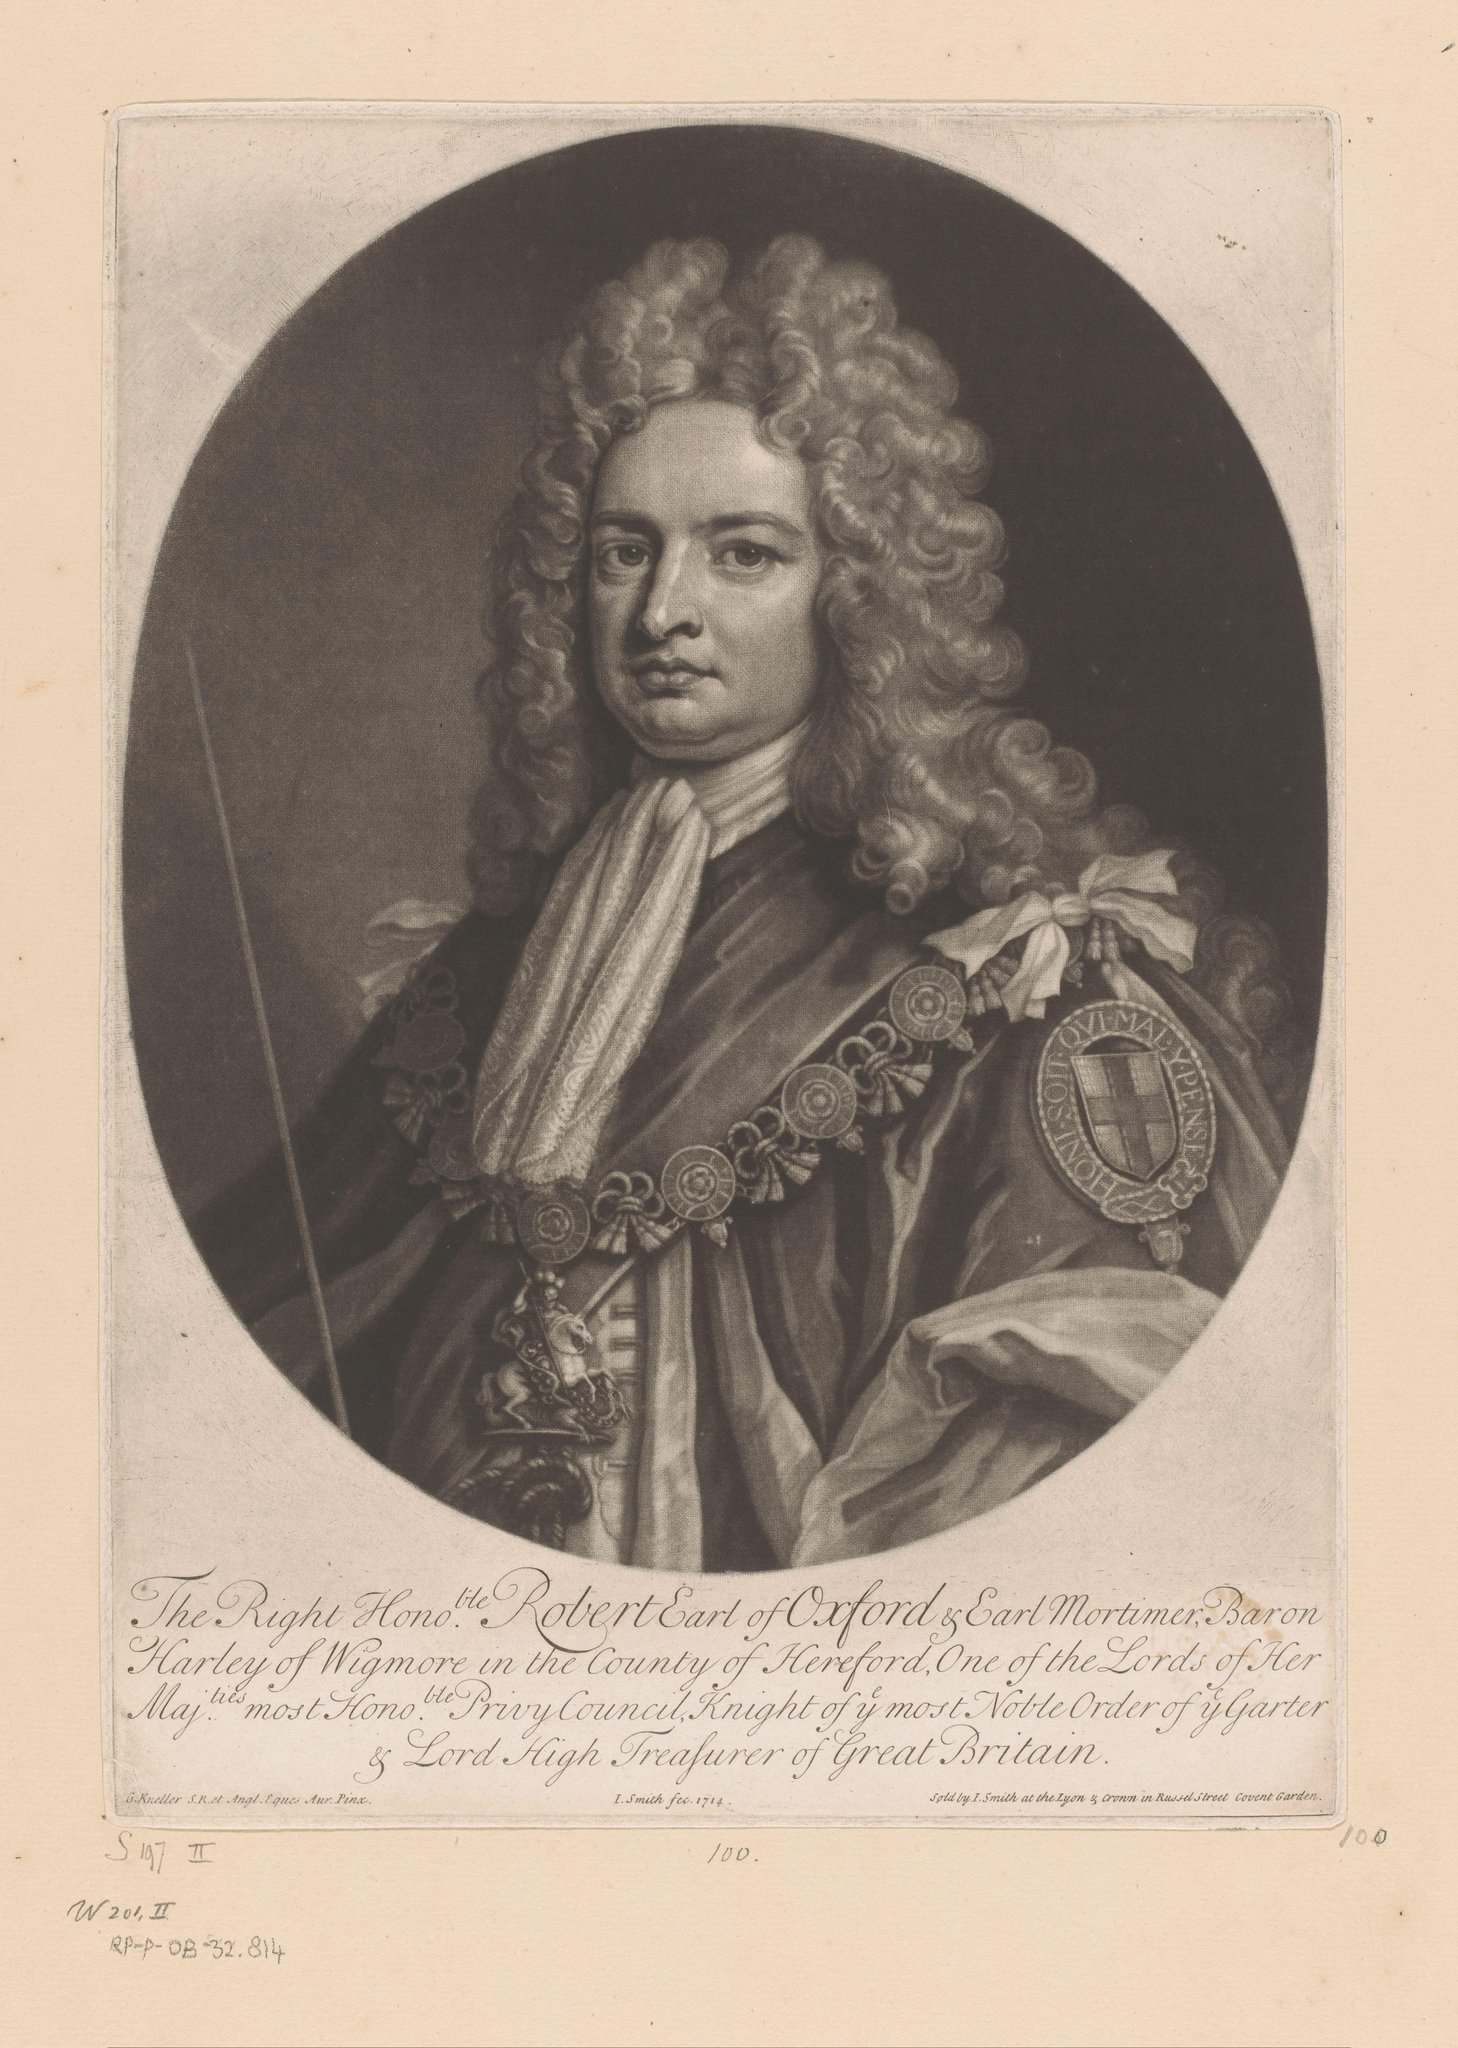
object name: print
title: Portret van Robert Harley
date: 1714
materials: paper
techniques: mezzotint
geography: london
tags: london, treasurer, sceptre, staff (symbol of sovereignty), historical persons, politician, e.g. party leader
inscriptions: collector's mark: Lugt 240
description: In zijn hand de witte staf van de groot-schatbewaarder van Engeland